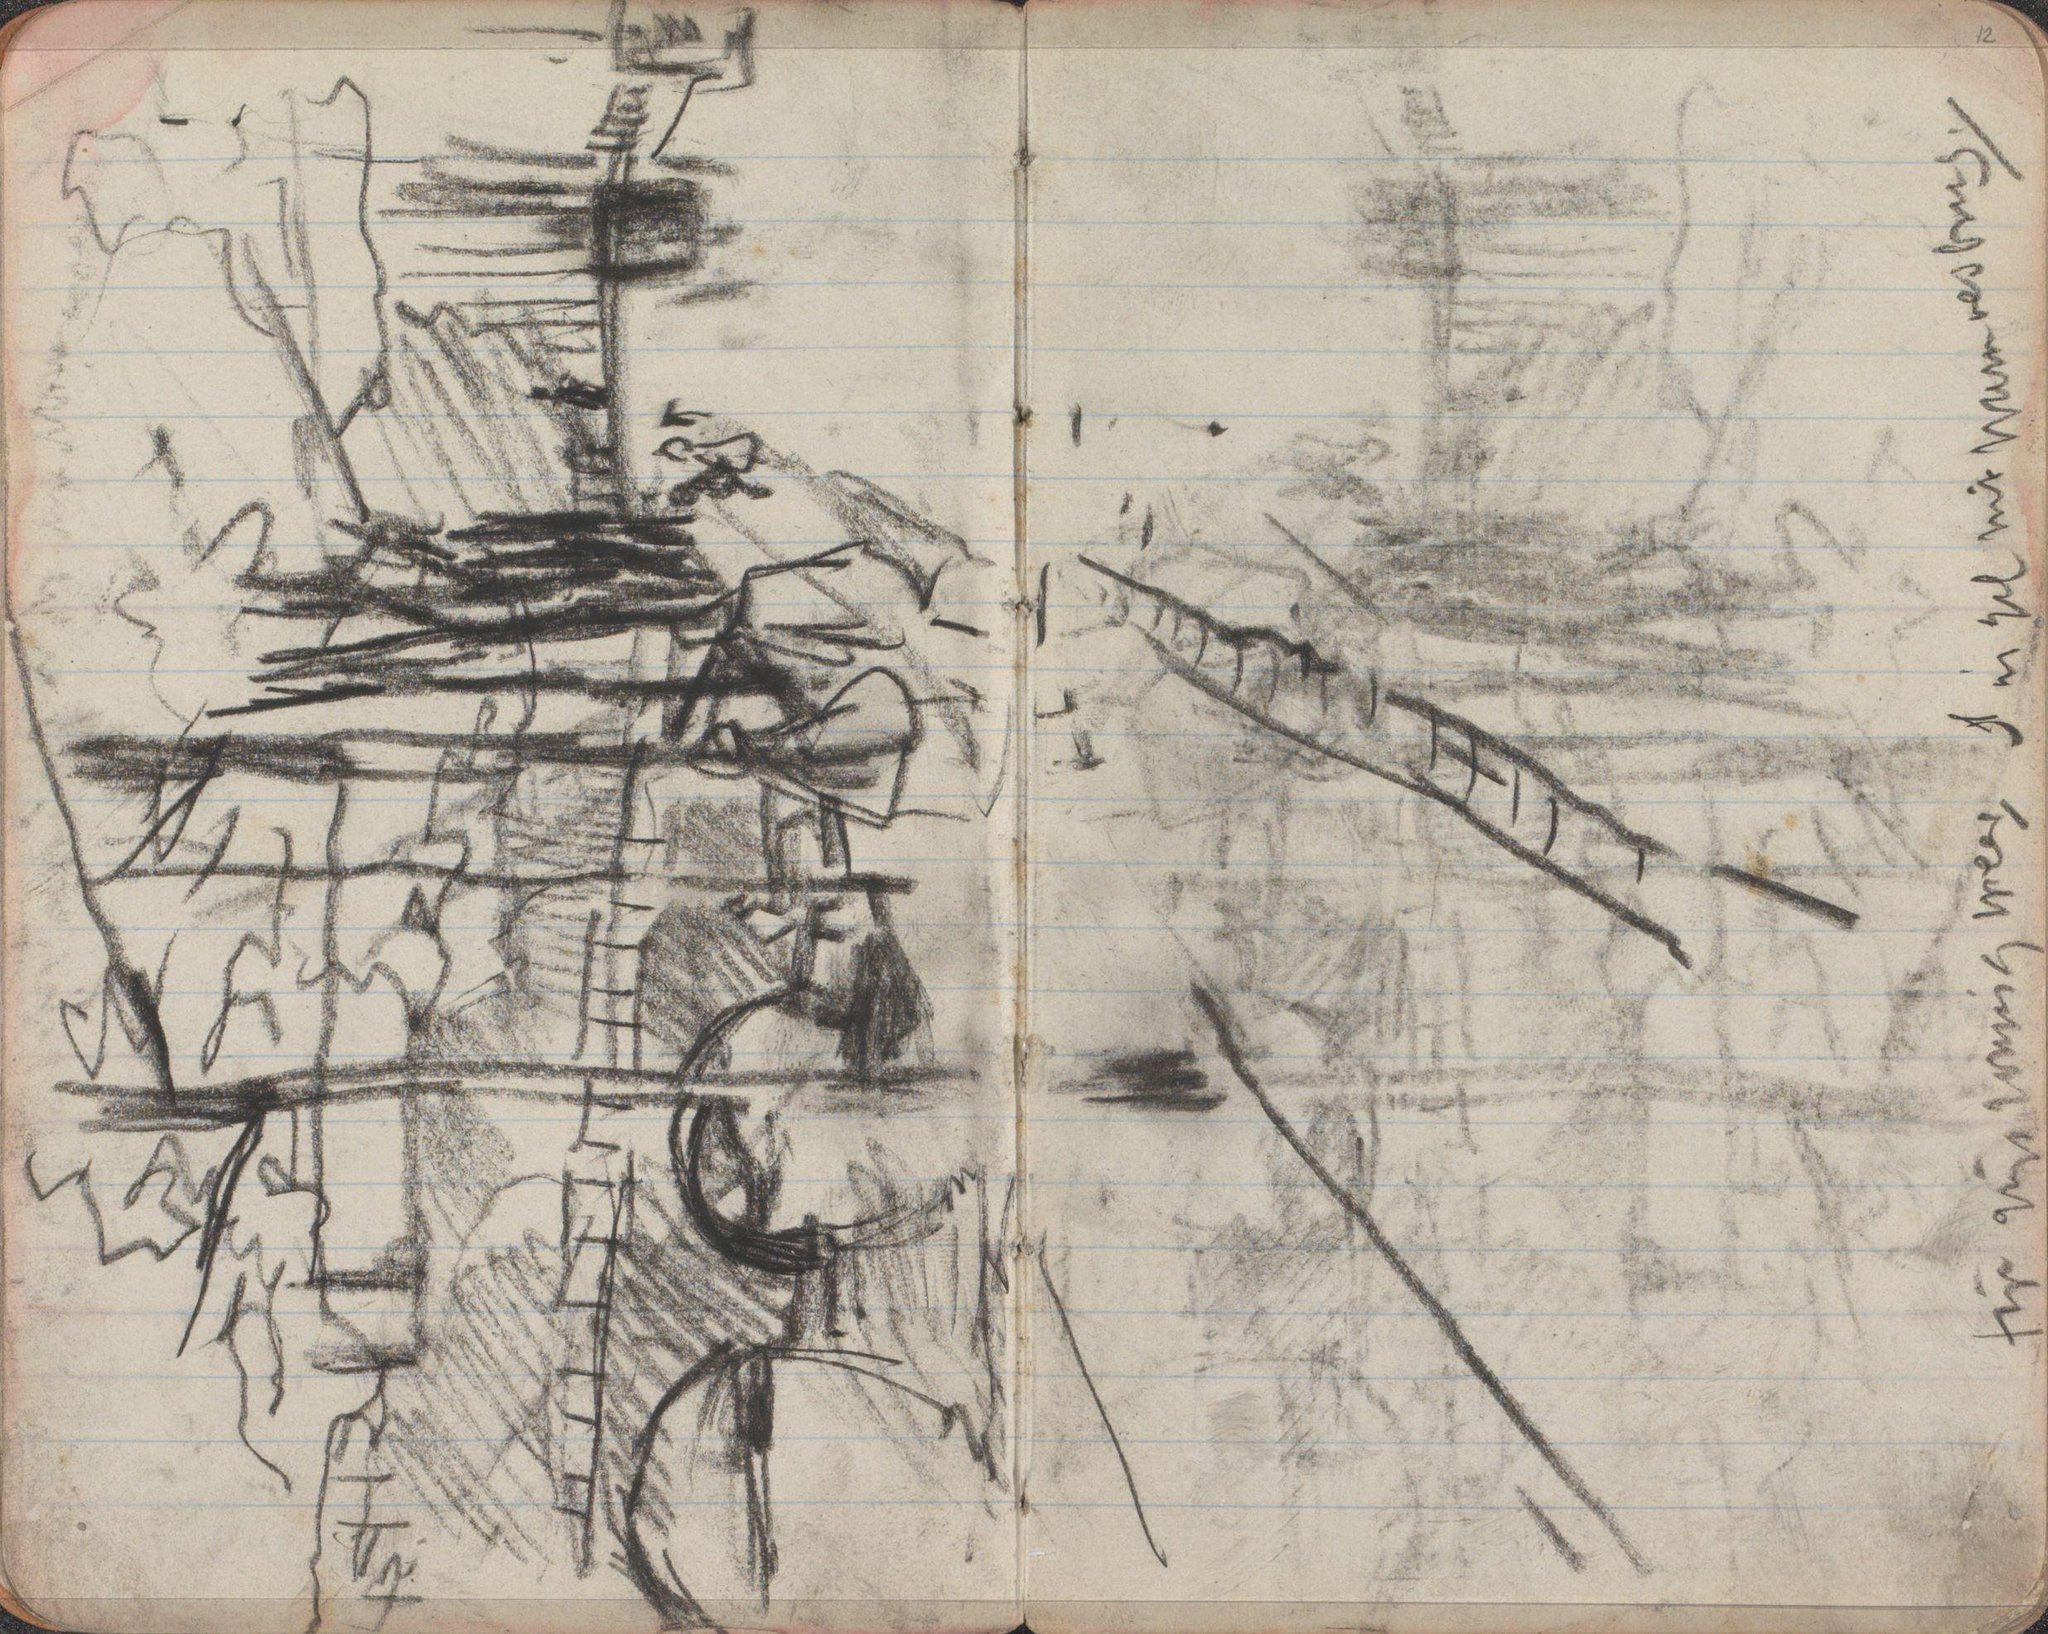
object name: sketchbook leaf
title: Gezicht op het Singel in Amsterdam met de Warmoesbrug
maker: george hendrik breitner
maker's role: draughtsman, painter, print maker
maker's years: 1857-1923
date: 1892-1900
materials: chalk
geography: amsterdam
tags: bridge in city across river, canal, etc. (+ city(-scape) with figures, staffage), civic architecture; edifices; dwellings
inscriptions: annotation: ‘[...] grijs zonnig weer, Singel met Warmoesbrug.’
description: Pagina 11 en pagina 12 uit een schetsboek met 38 bladen.